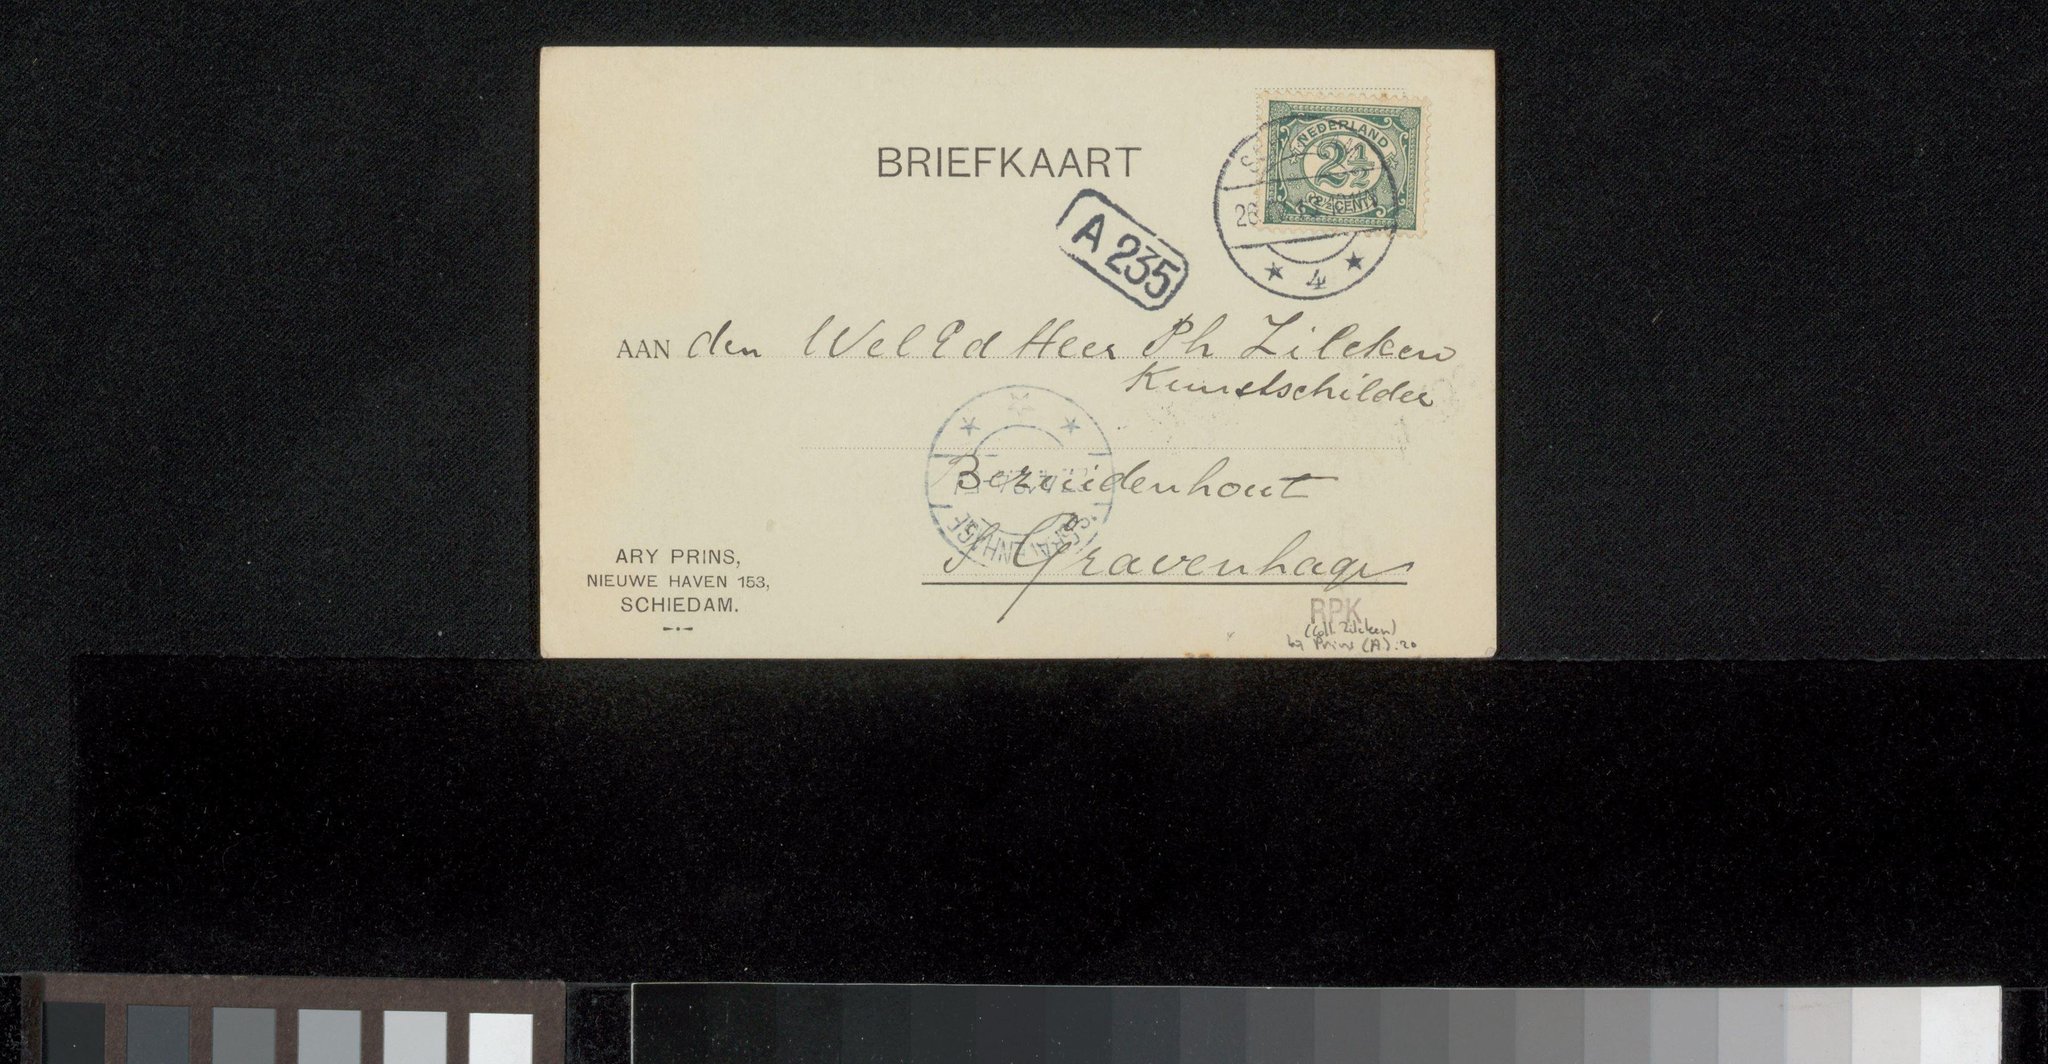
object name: postcard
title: Briefkaart aan Philip Zilcken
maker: arij prins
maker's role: industrieel, schrijver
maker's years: 1860-1922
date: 1913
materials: cardboard, ink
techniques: pen, writing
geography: schiedam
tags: the hague, painter, philip zilcken, exhibition ~ art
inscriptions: collector's mark: ‘RPK’